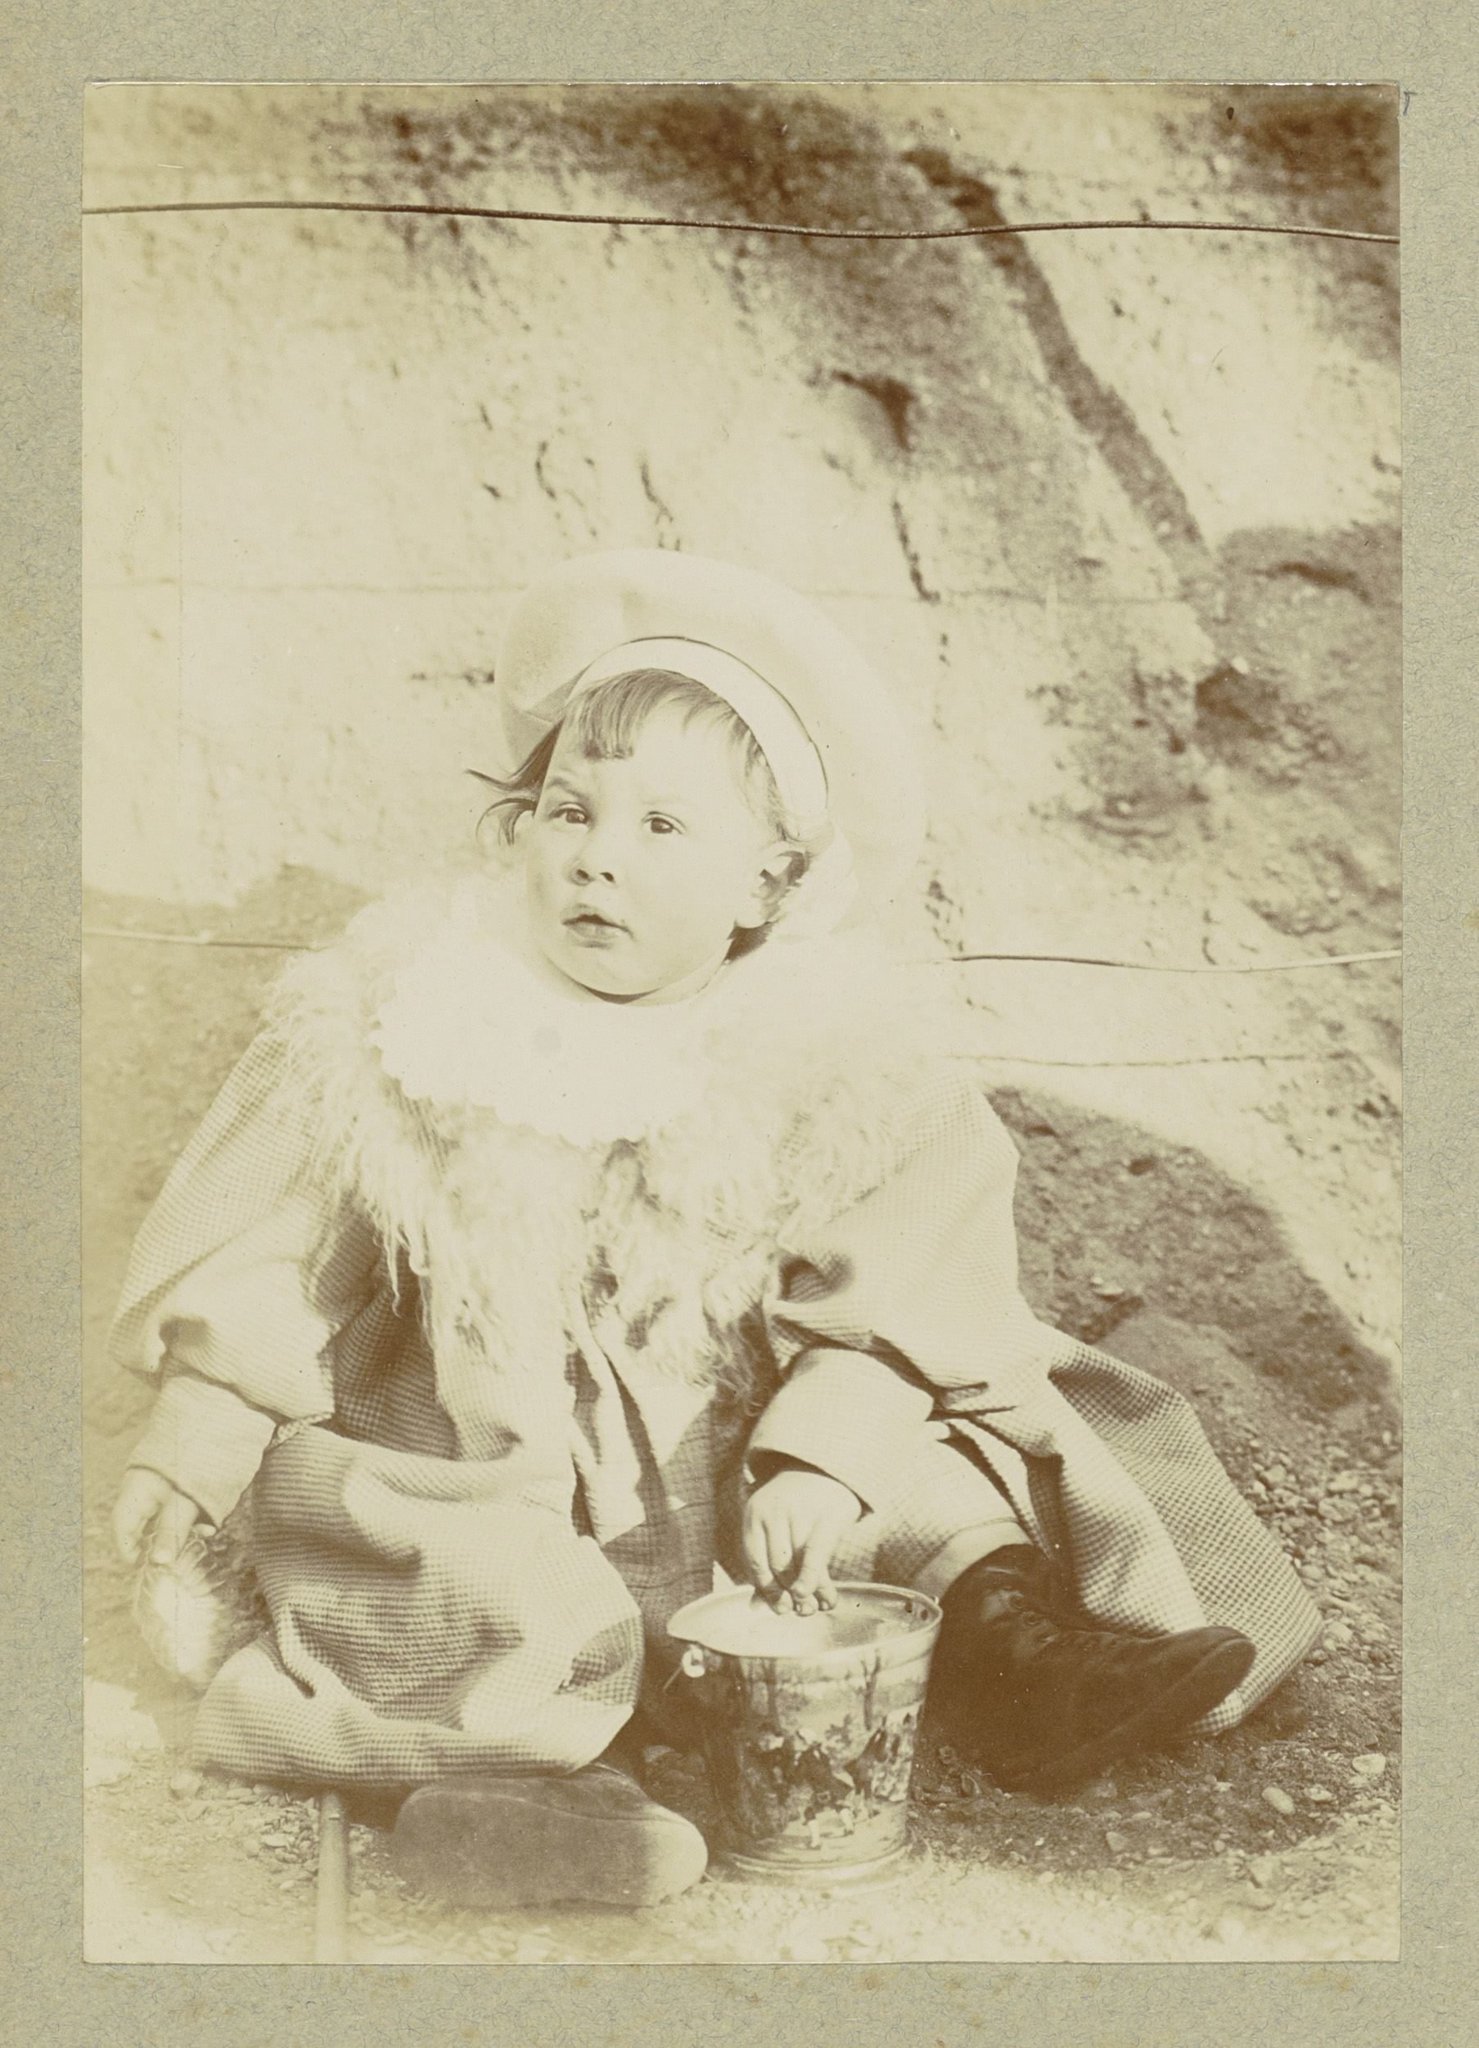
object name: photograph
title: Portret van een jong kind met een jas, een sjaal en een muts, zittend bij een speelgoedemmer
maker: Anonymous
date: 1885-1914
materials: photographic support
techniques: gelatin silver print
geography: france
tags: (playing with) toys ~ water, child, france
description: Onderdeel van Fotoalbum met familiefoto's.